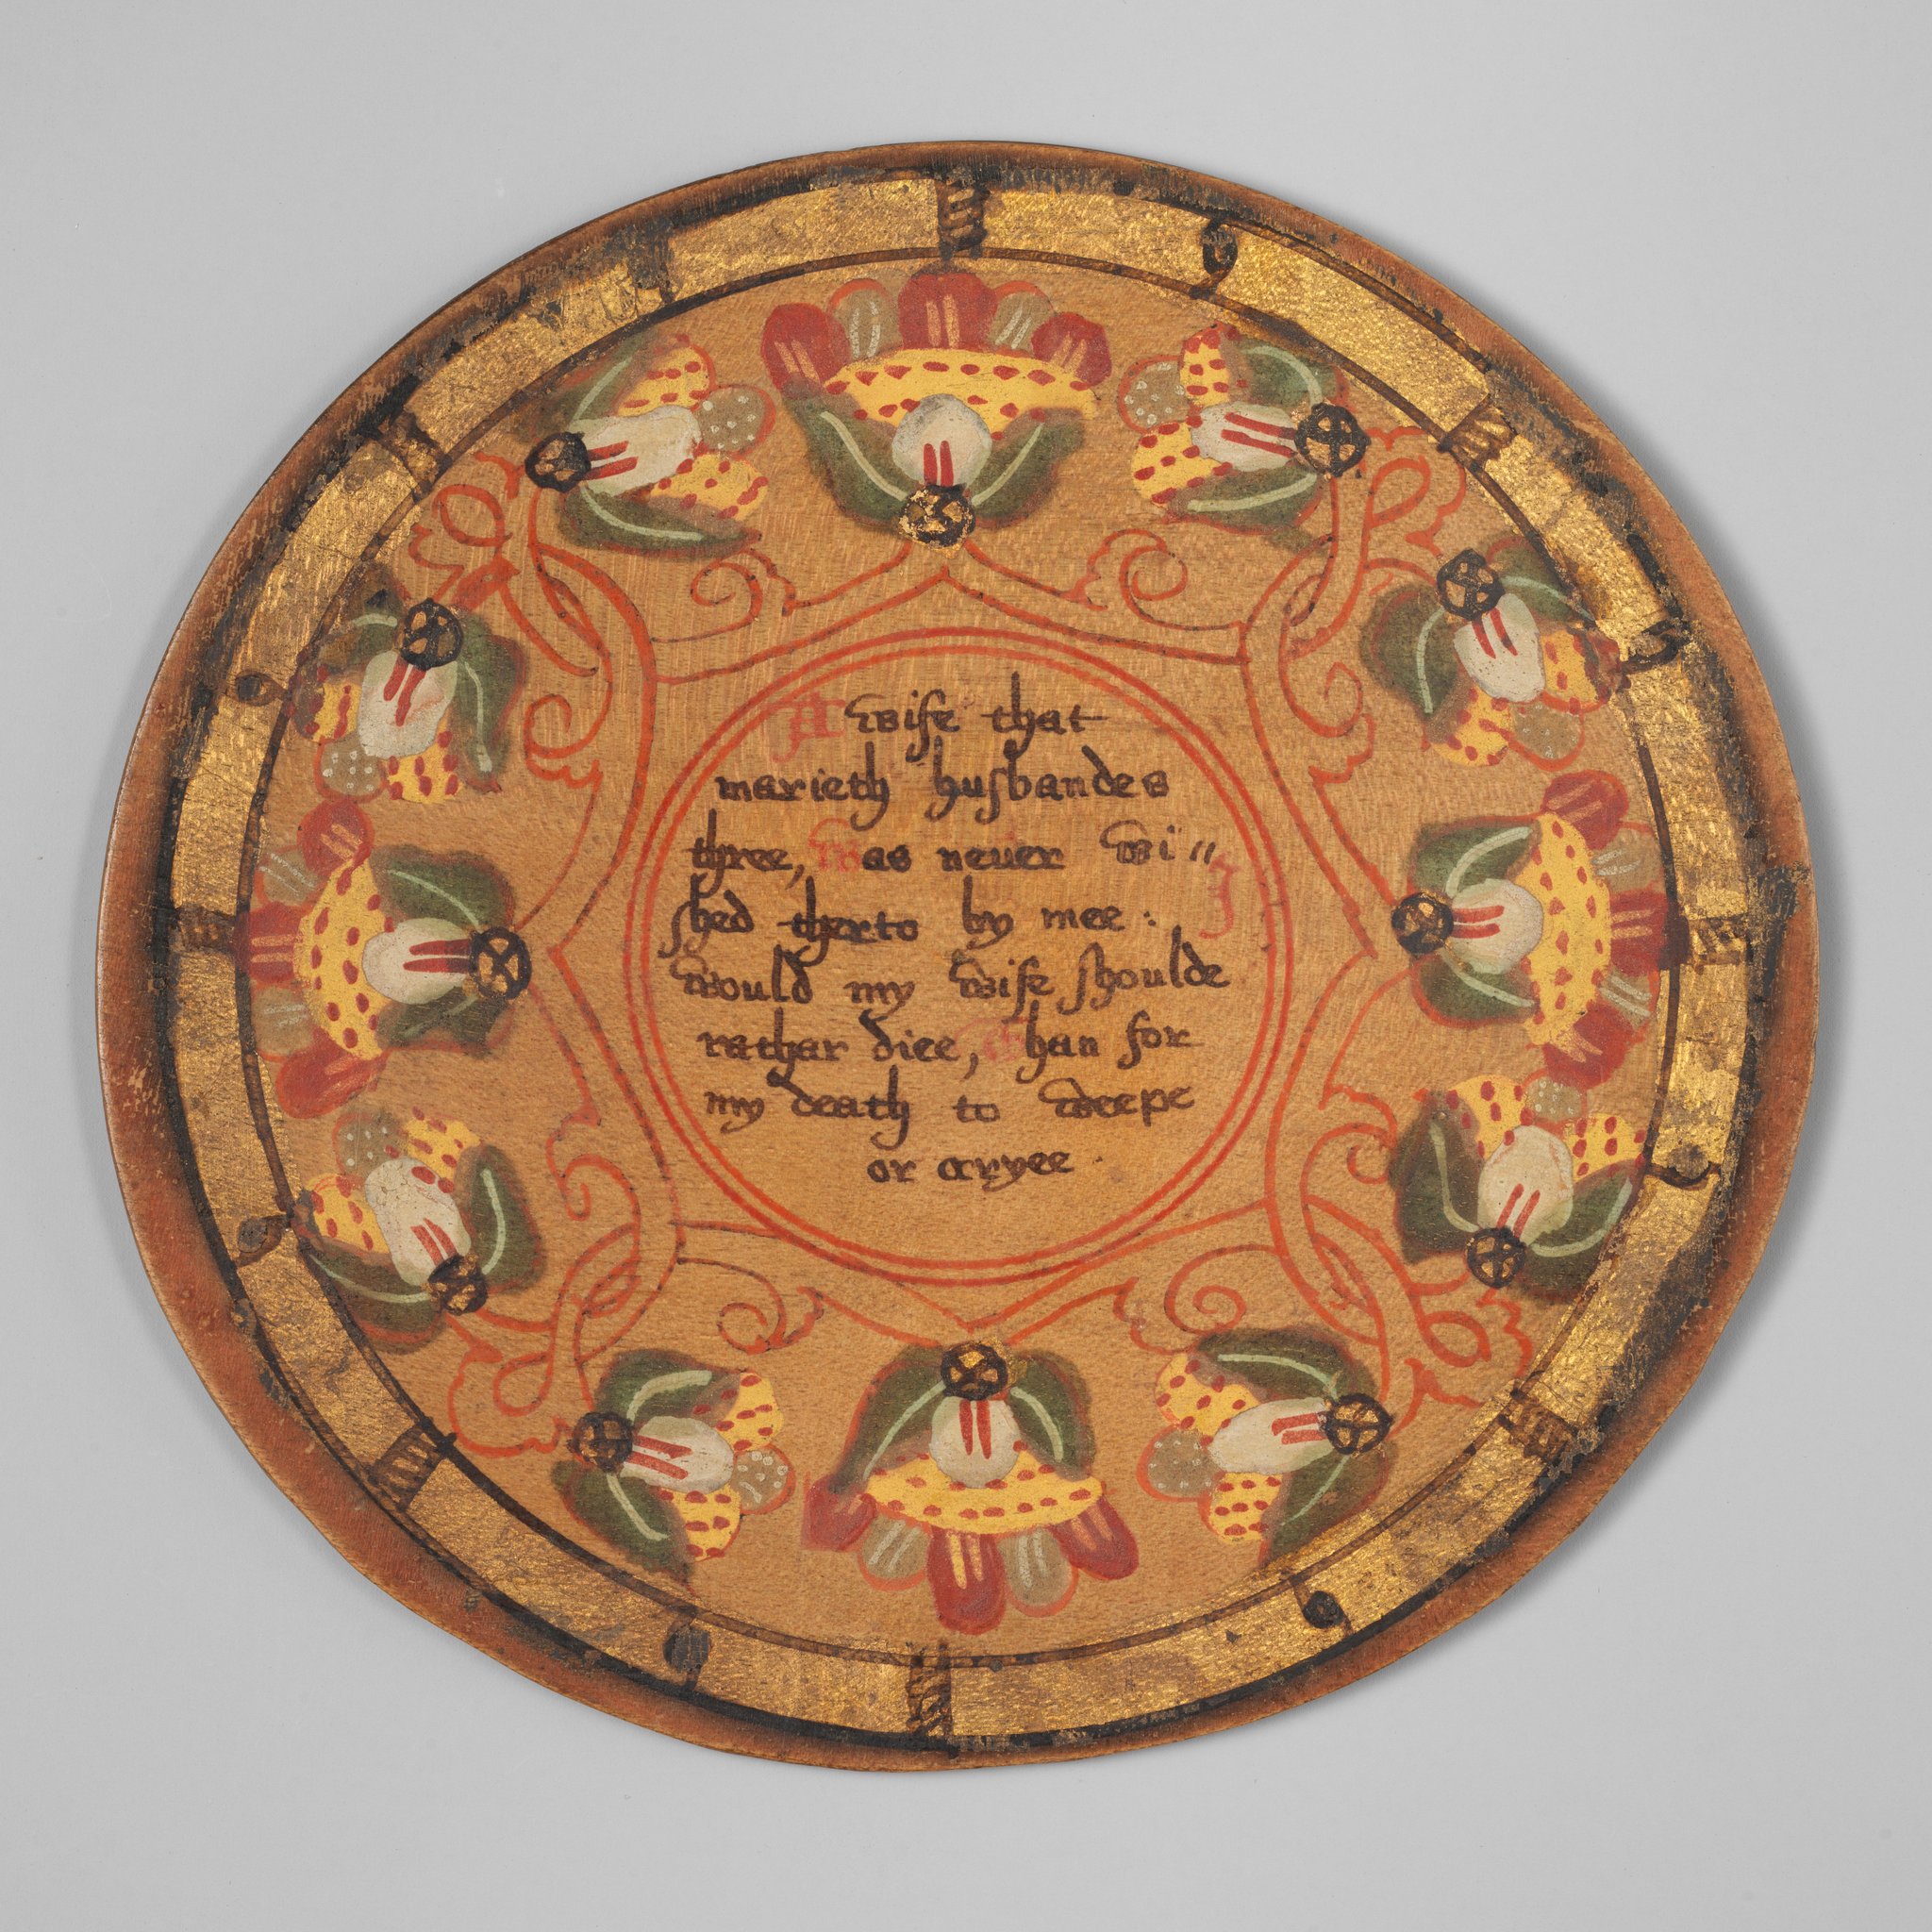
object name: trencher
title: Trencher (one of a set)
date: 1567-1633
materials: ink, wood, varnish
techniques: painting, silvered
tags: coat of arms